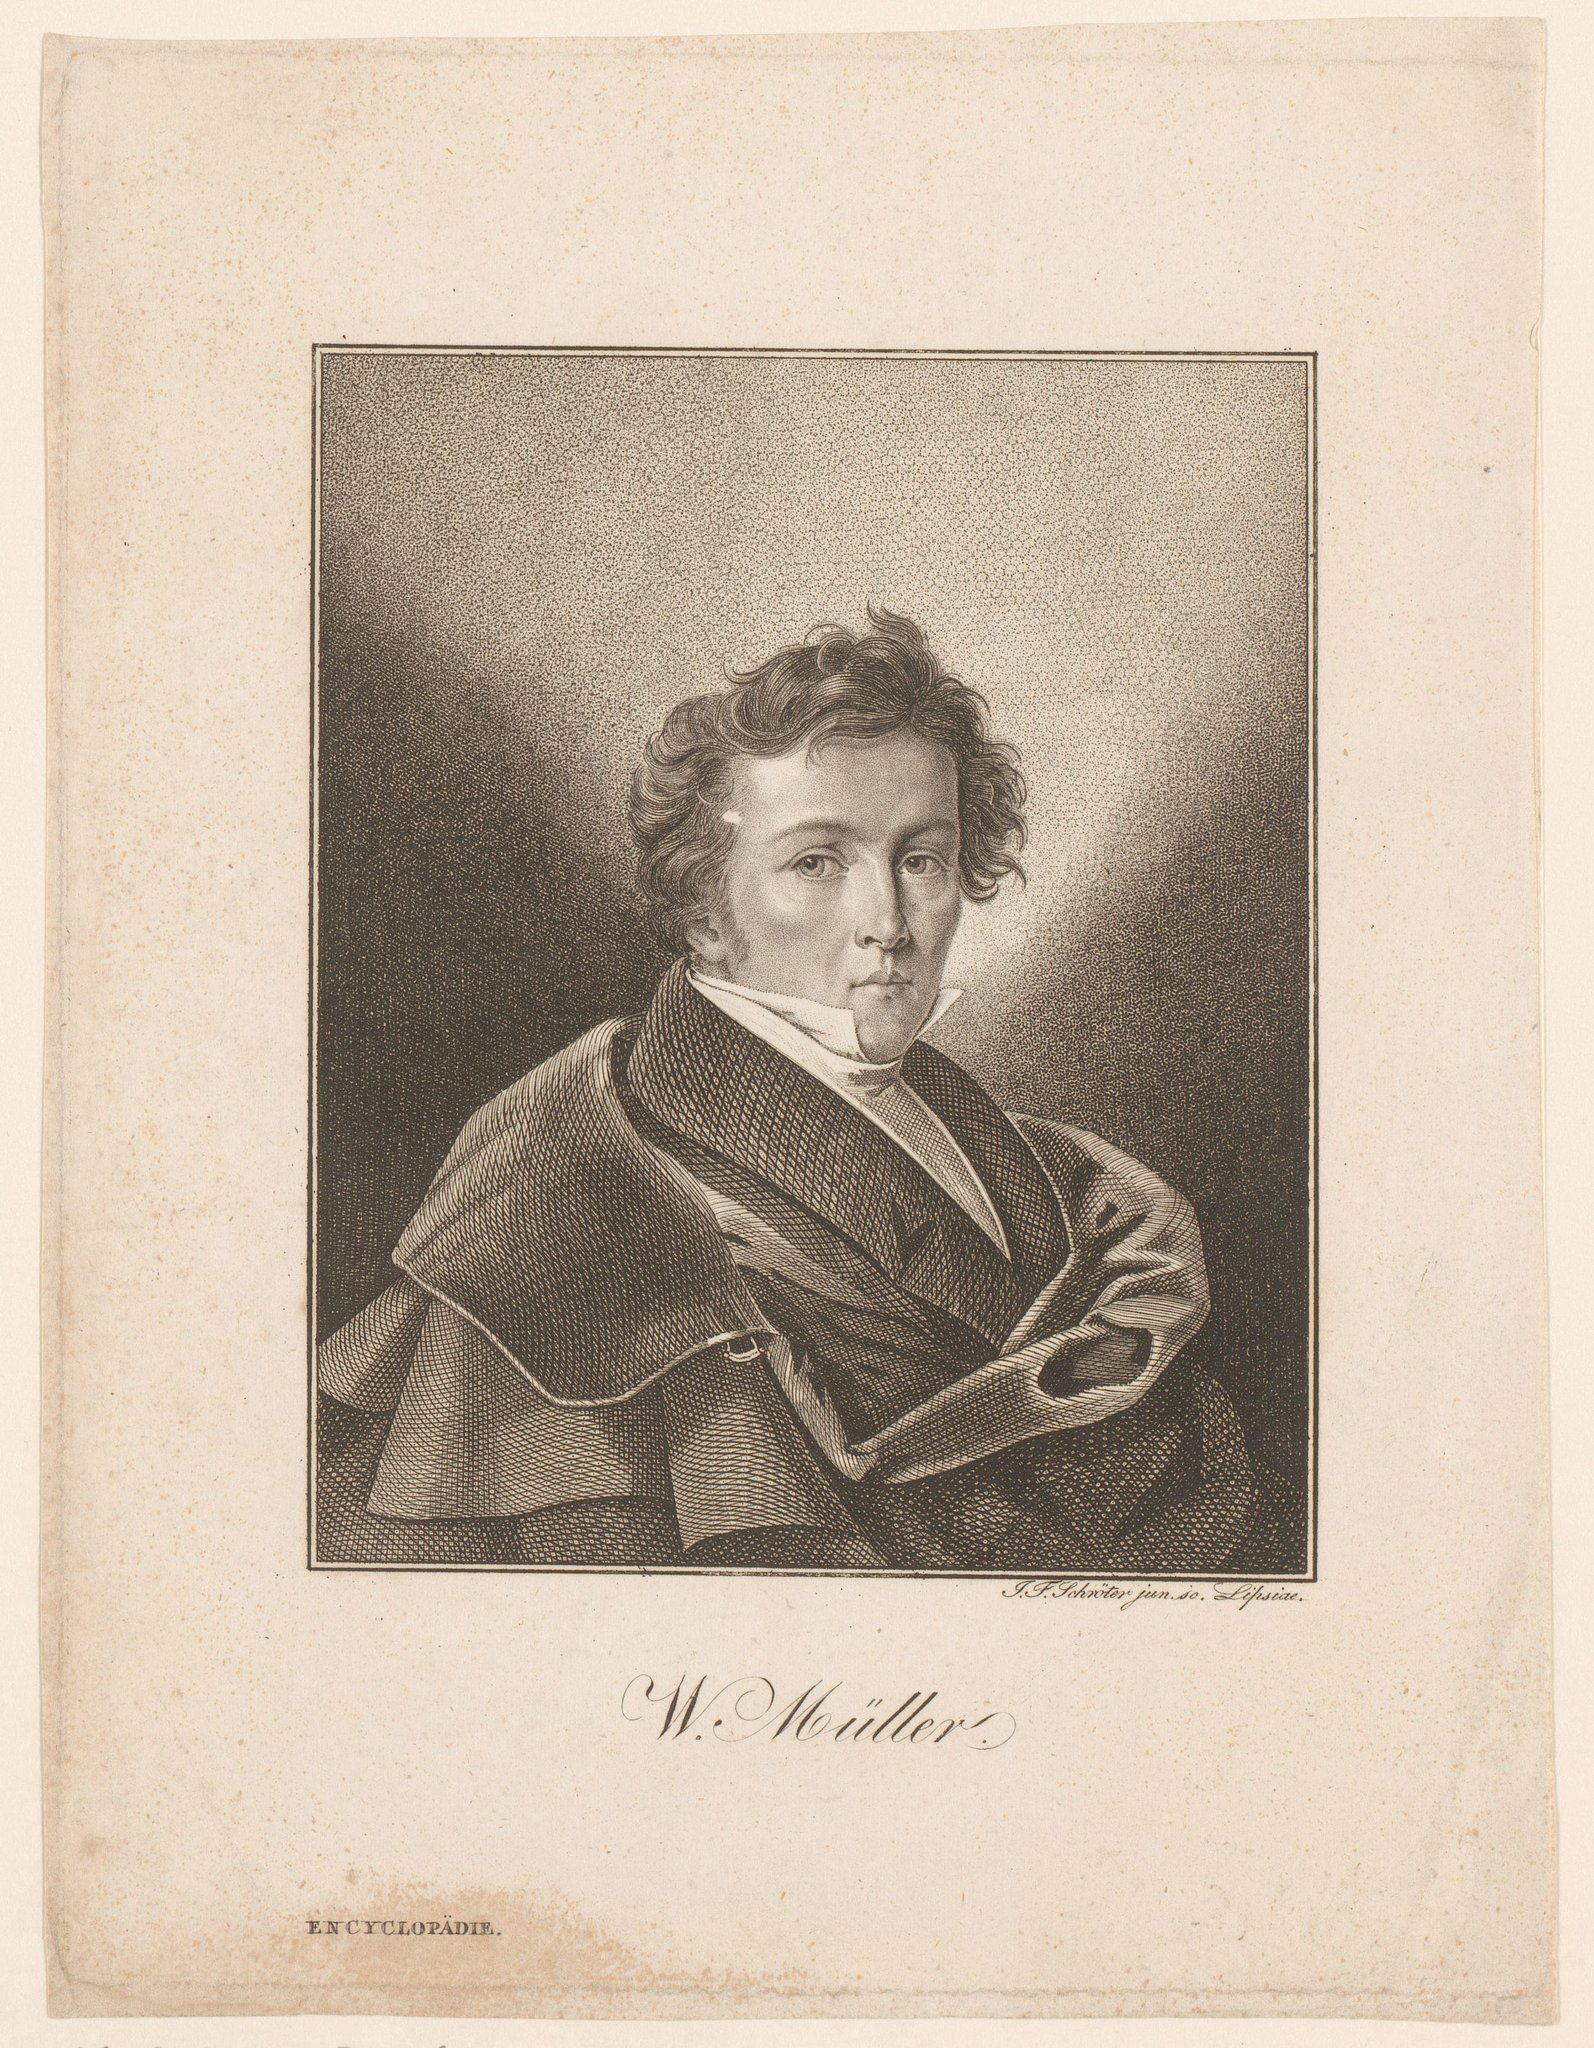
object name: print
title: Portret van Wilhelm Müller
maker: johan friedrich schrötter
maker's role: print maker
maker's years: 1770-1836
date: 1804-1836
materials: paper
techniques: engraving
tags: historical persons, writer, poet, author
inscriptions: collector's mark: Lugt 2228